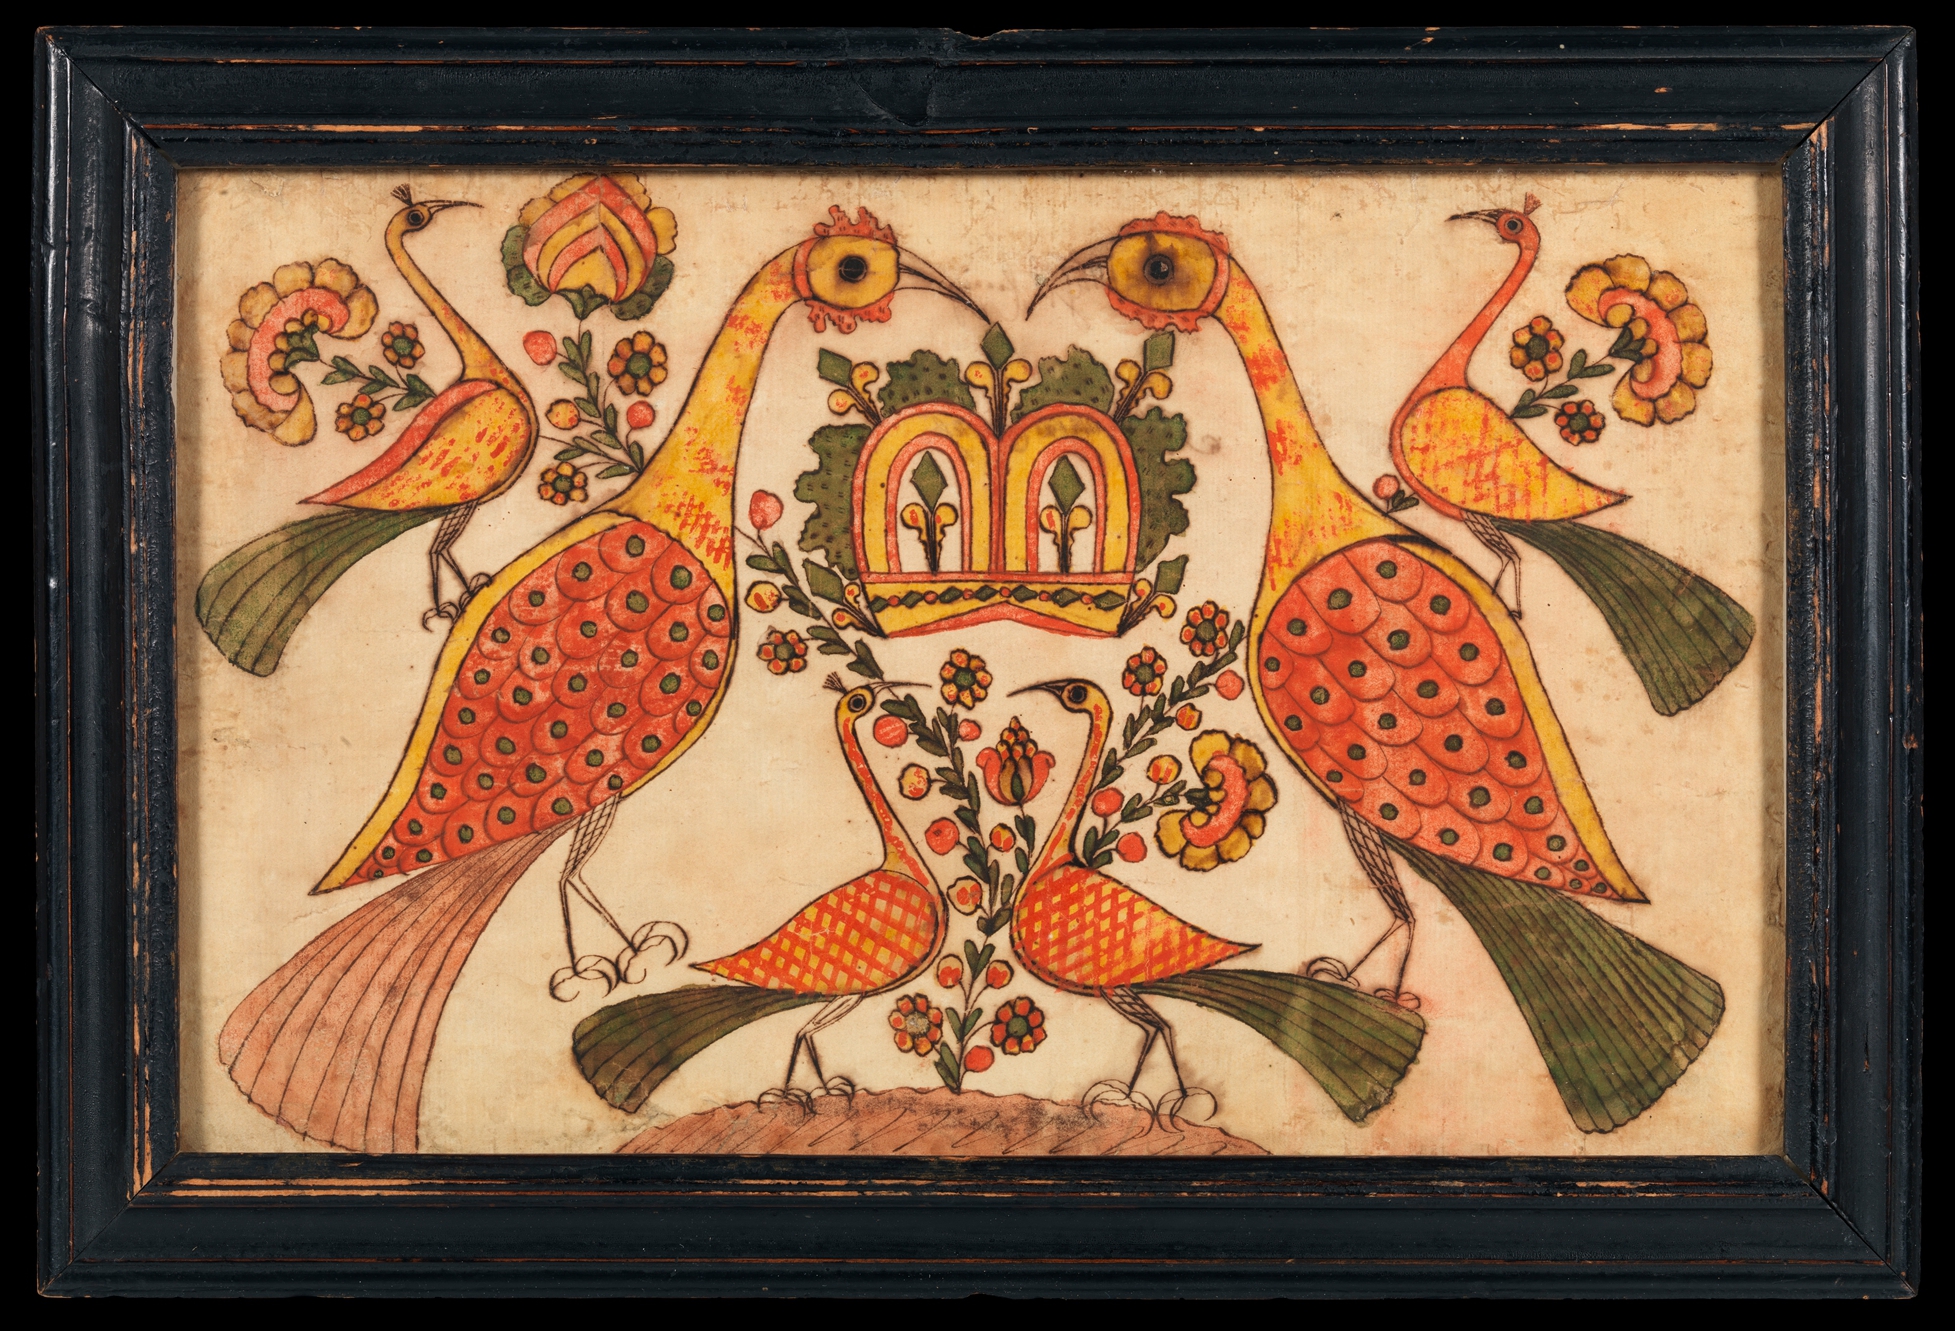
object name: drawing, fraktur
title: Fraktur Motifs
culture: american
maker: johann heinrich otto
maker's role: maker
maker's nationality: american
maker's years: 1730-1800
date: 1780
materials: ink, iron, paper, watercolor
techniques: pen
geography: united states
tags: birds,flowers,leaves